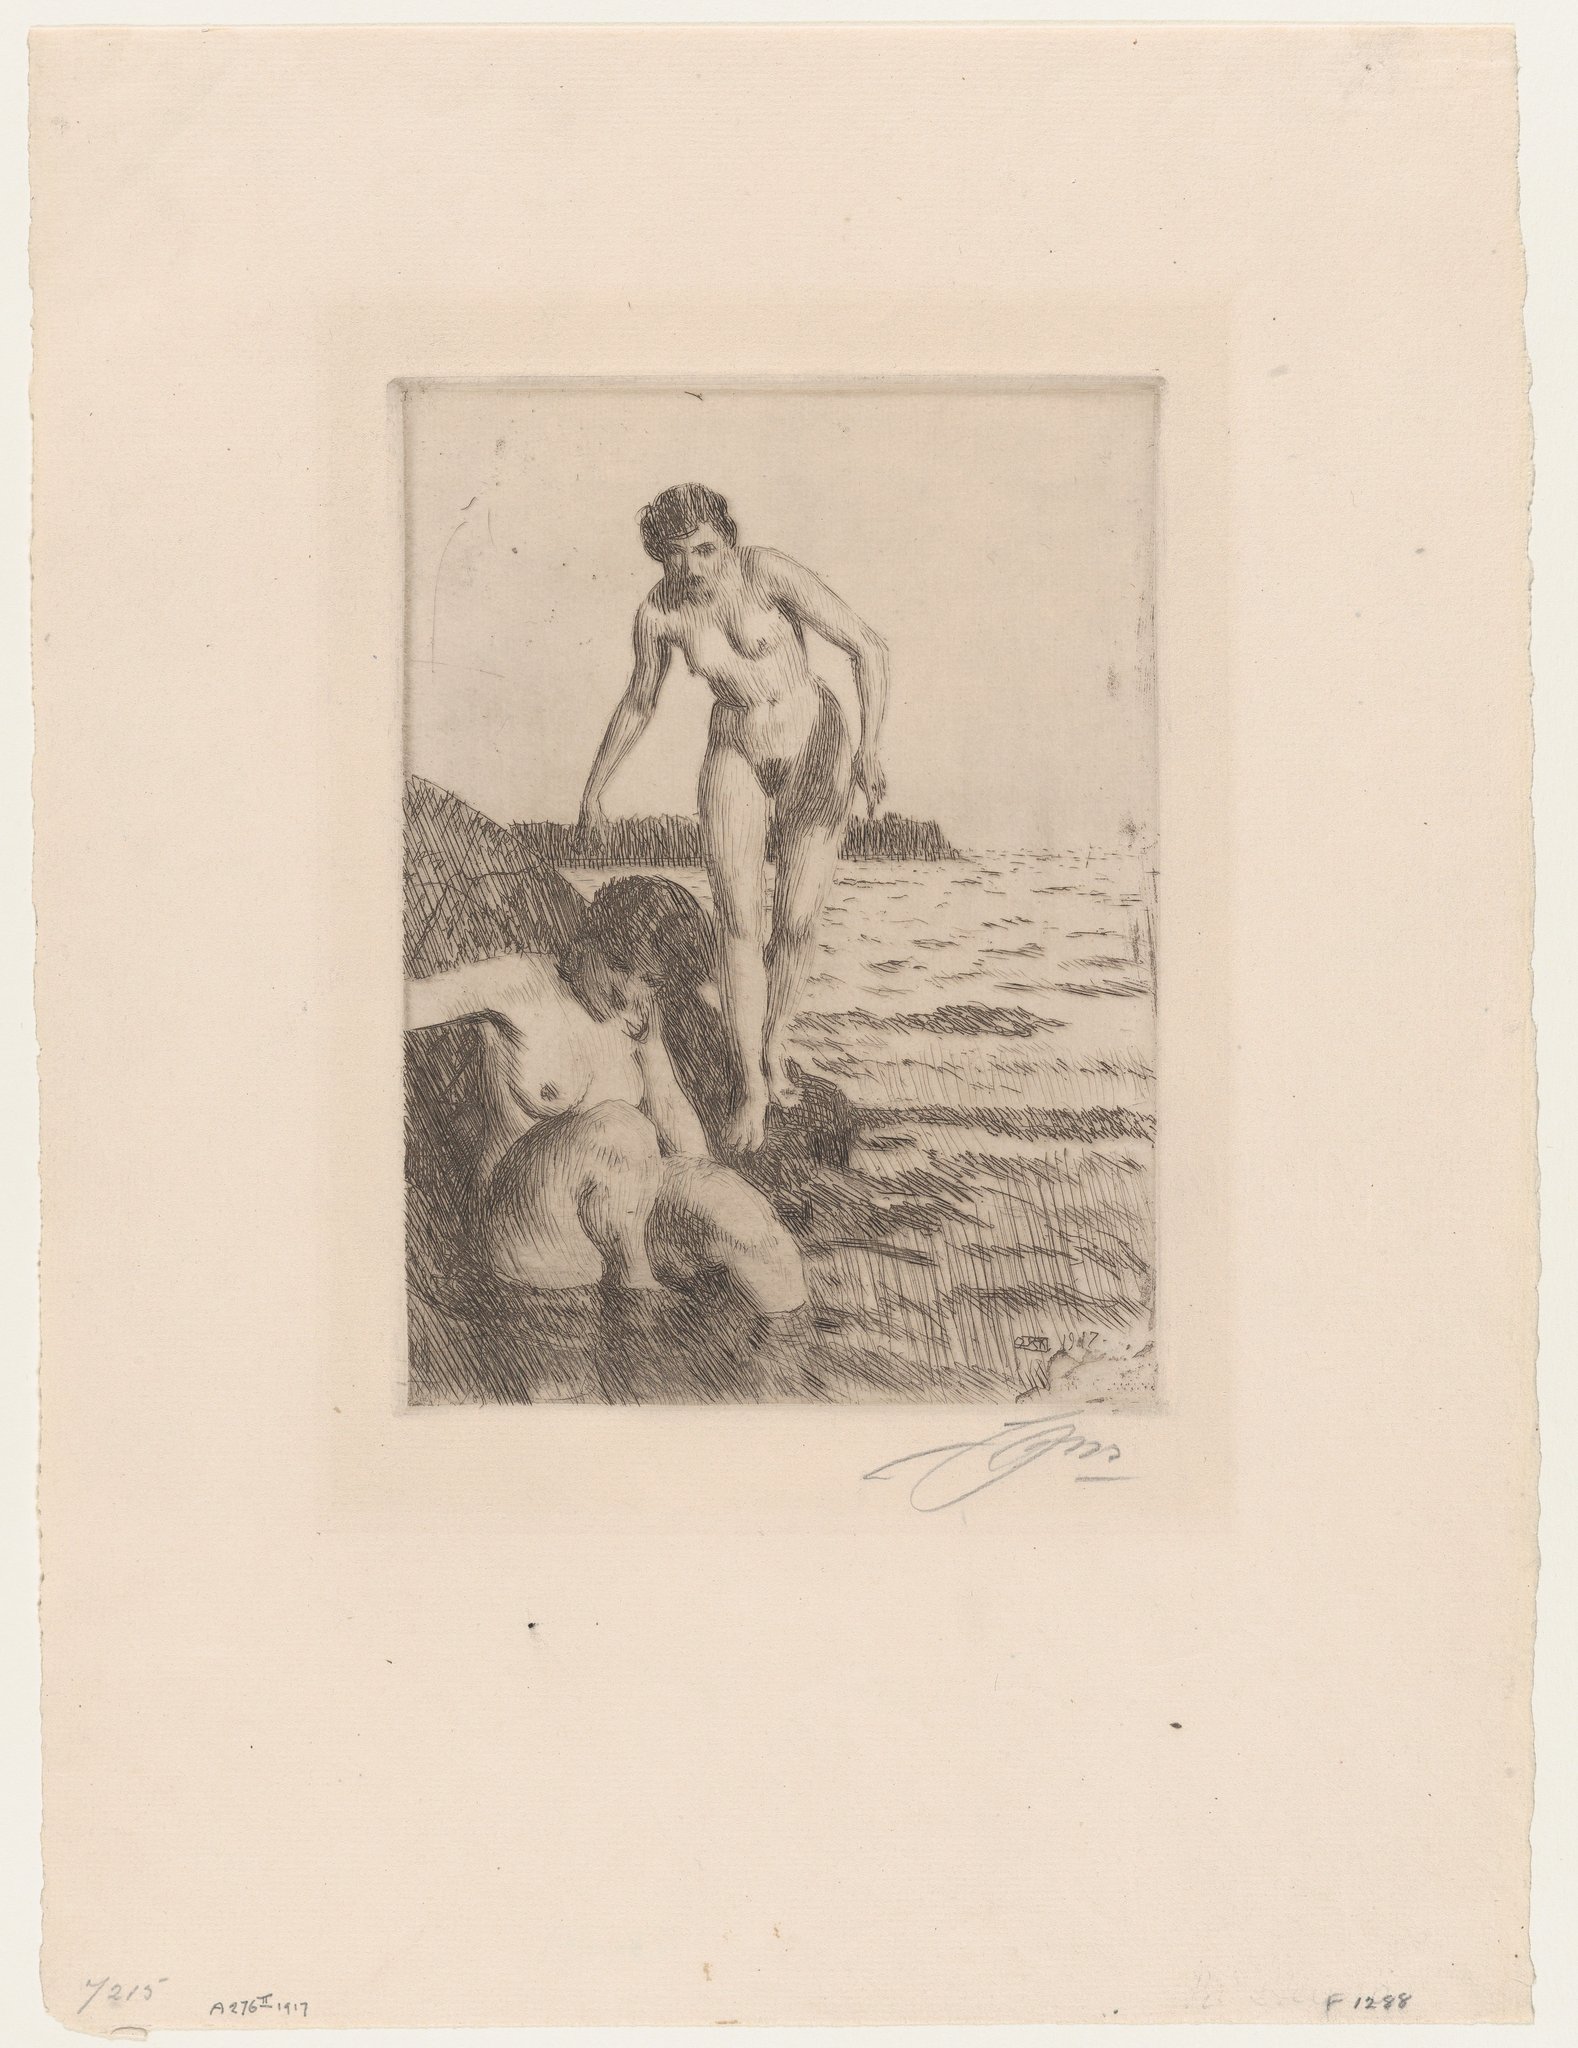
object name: print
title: On Hemsö Island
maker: anders zorn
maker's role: artist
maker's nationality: swedish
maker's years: 1860-1920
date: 1917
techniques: etching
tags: female nudes,bathing